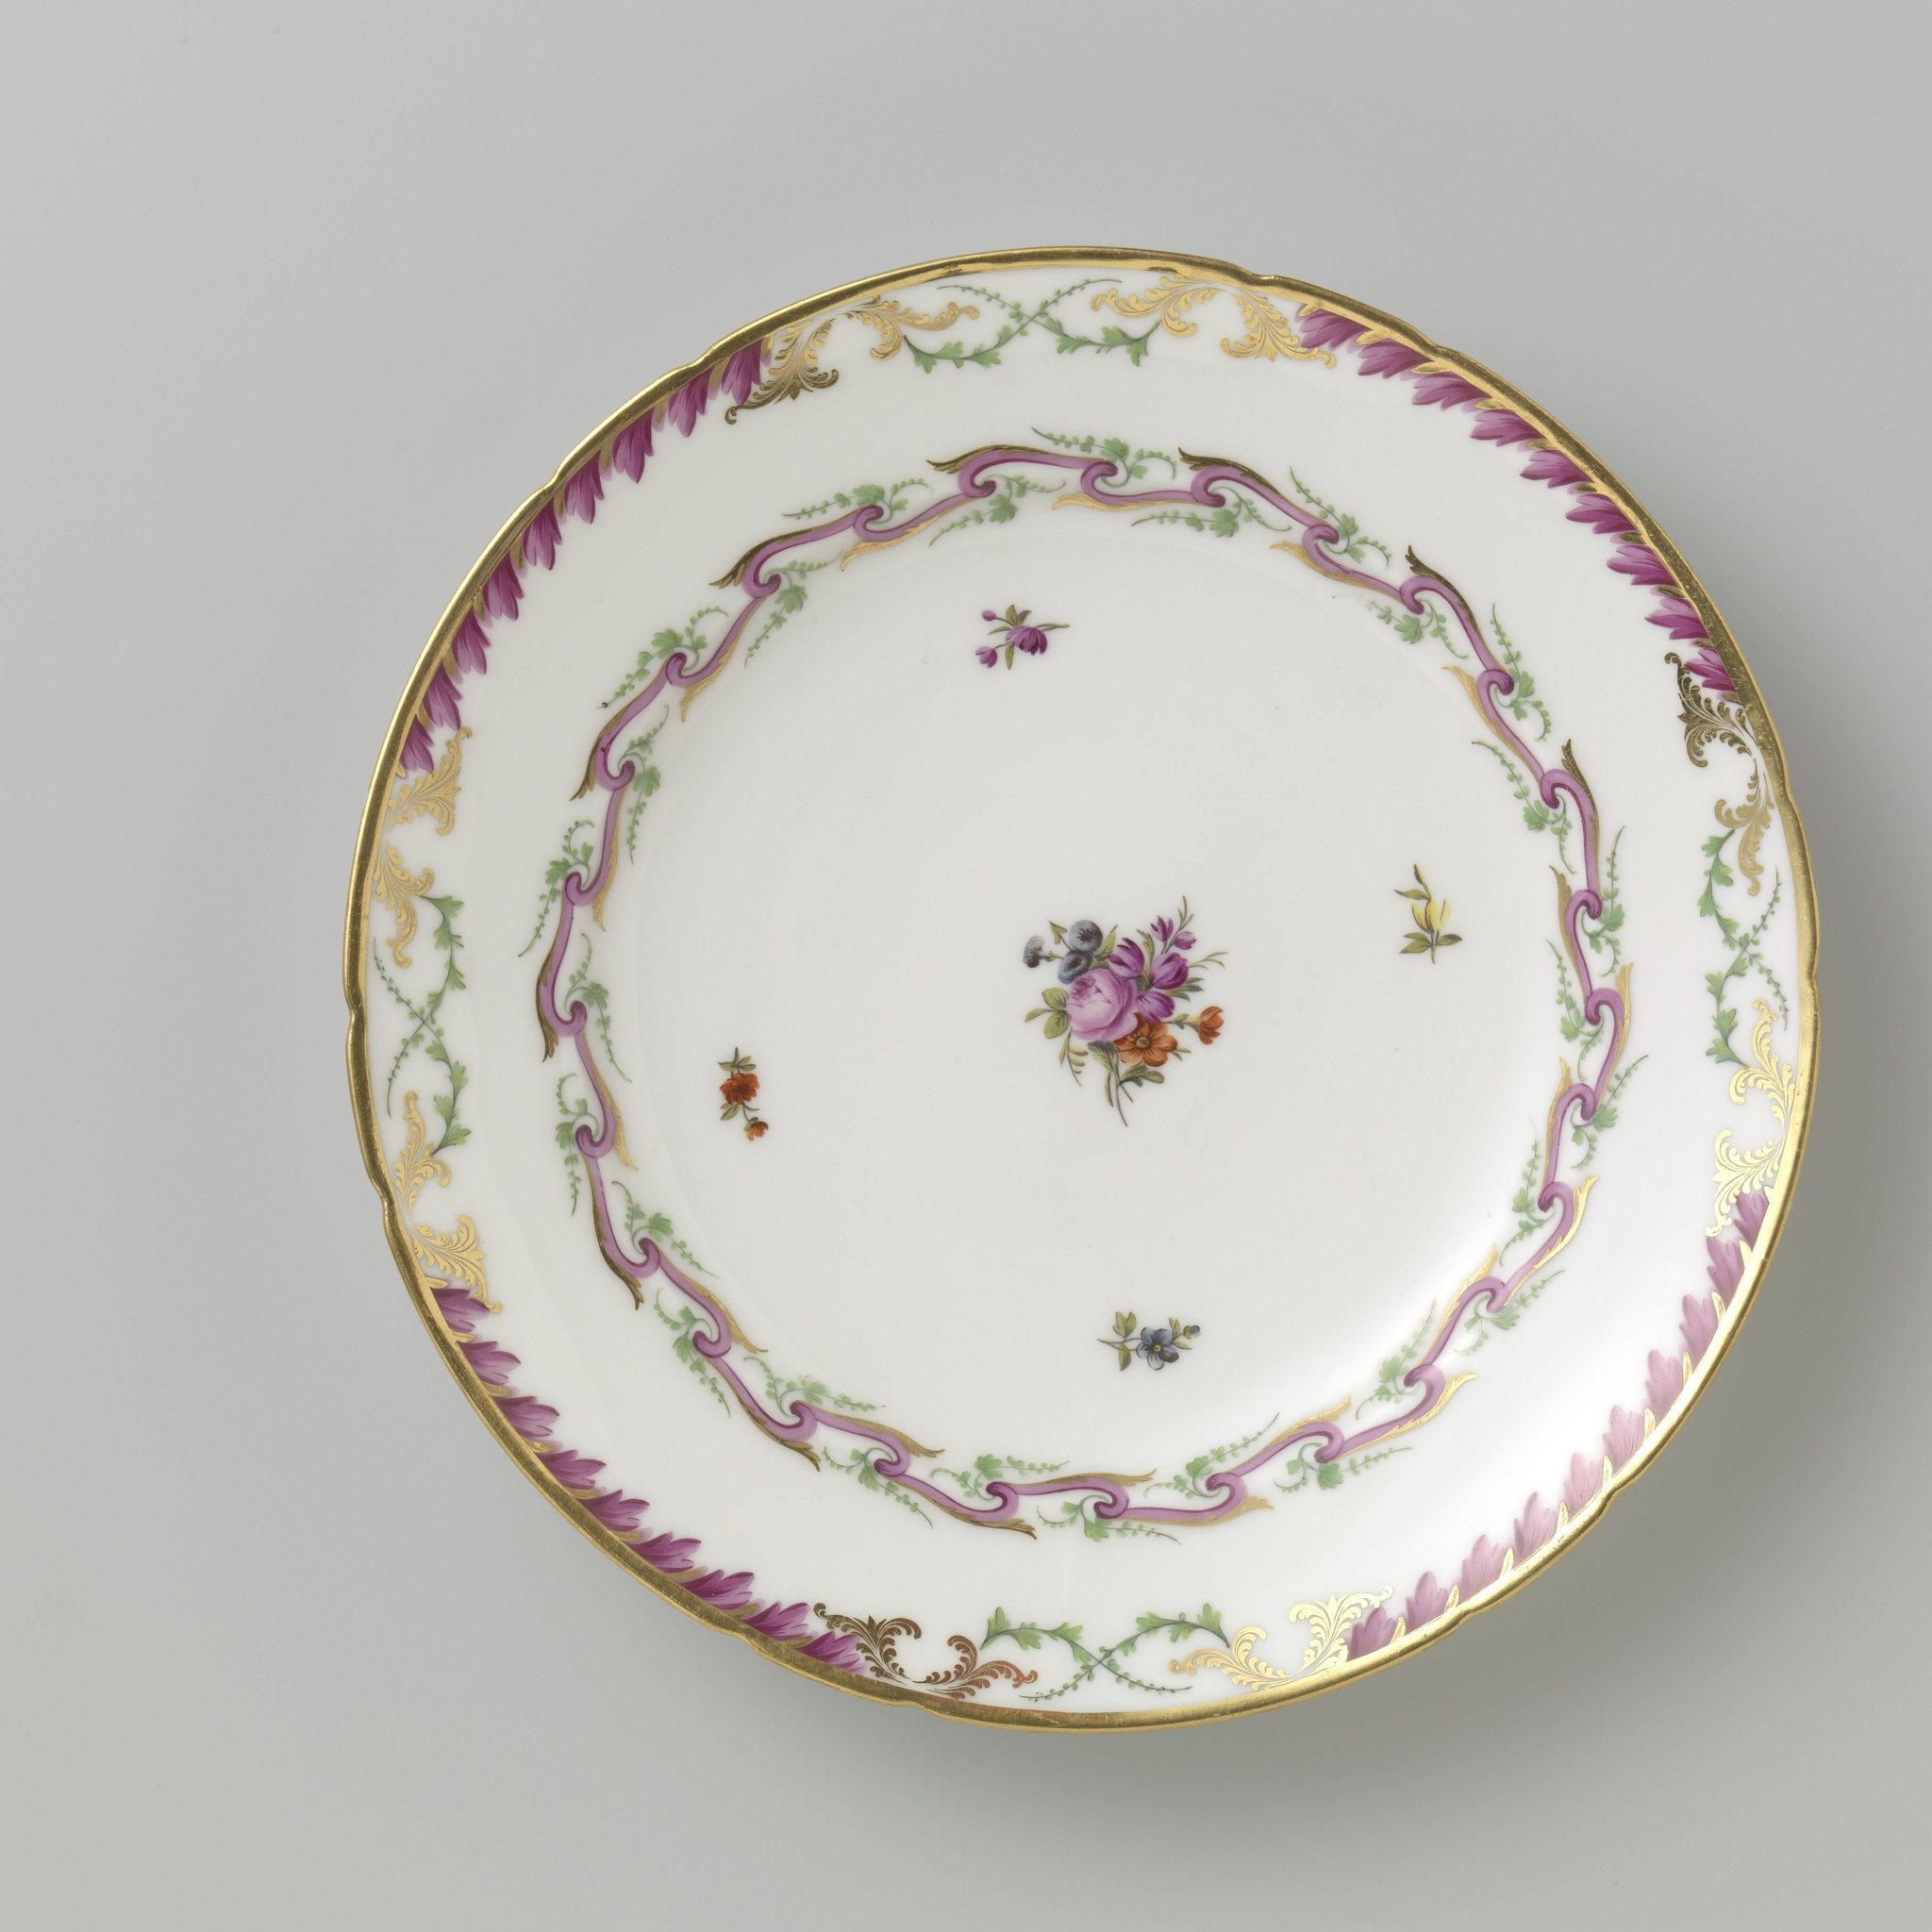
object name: plate dish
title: Bord, plat model, behorend bij een servies met geslingerd lintmotief met bladertakken, bloemboeketten en gestrooide bloemtakken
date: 1780-1820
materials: porcelain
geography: loosdrecht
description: Bord, plat model, behorend bij een servies van porselein met geslingerd lintmotief in paars en goud met groene bladertakken, bloemboeketten en gestrooide bloemtakken. Randen lichtgegolfd met decoratie in goud met paars bladmotief waartussen groen gekruist bladmotief. Gemerkt: M.O.L. of AMSTEL.